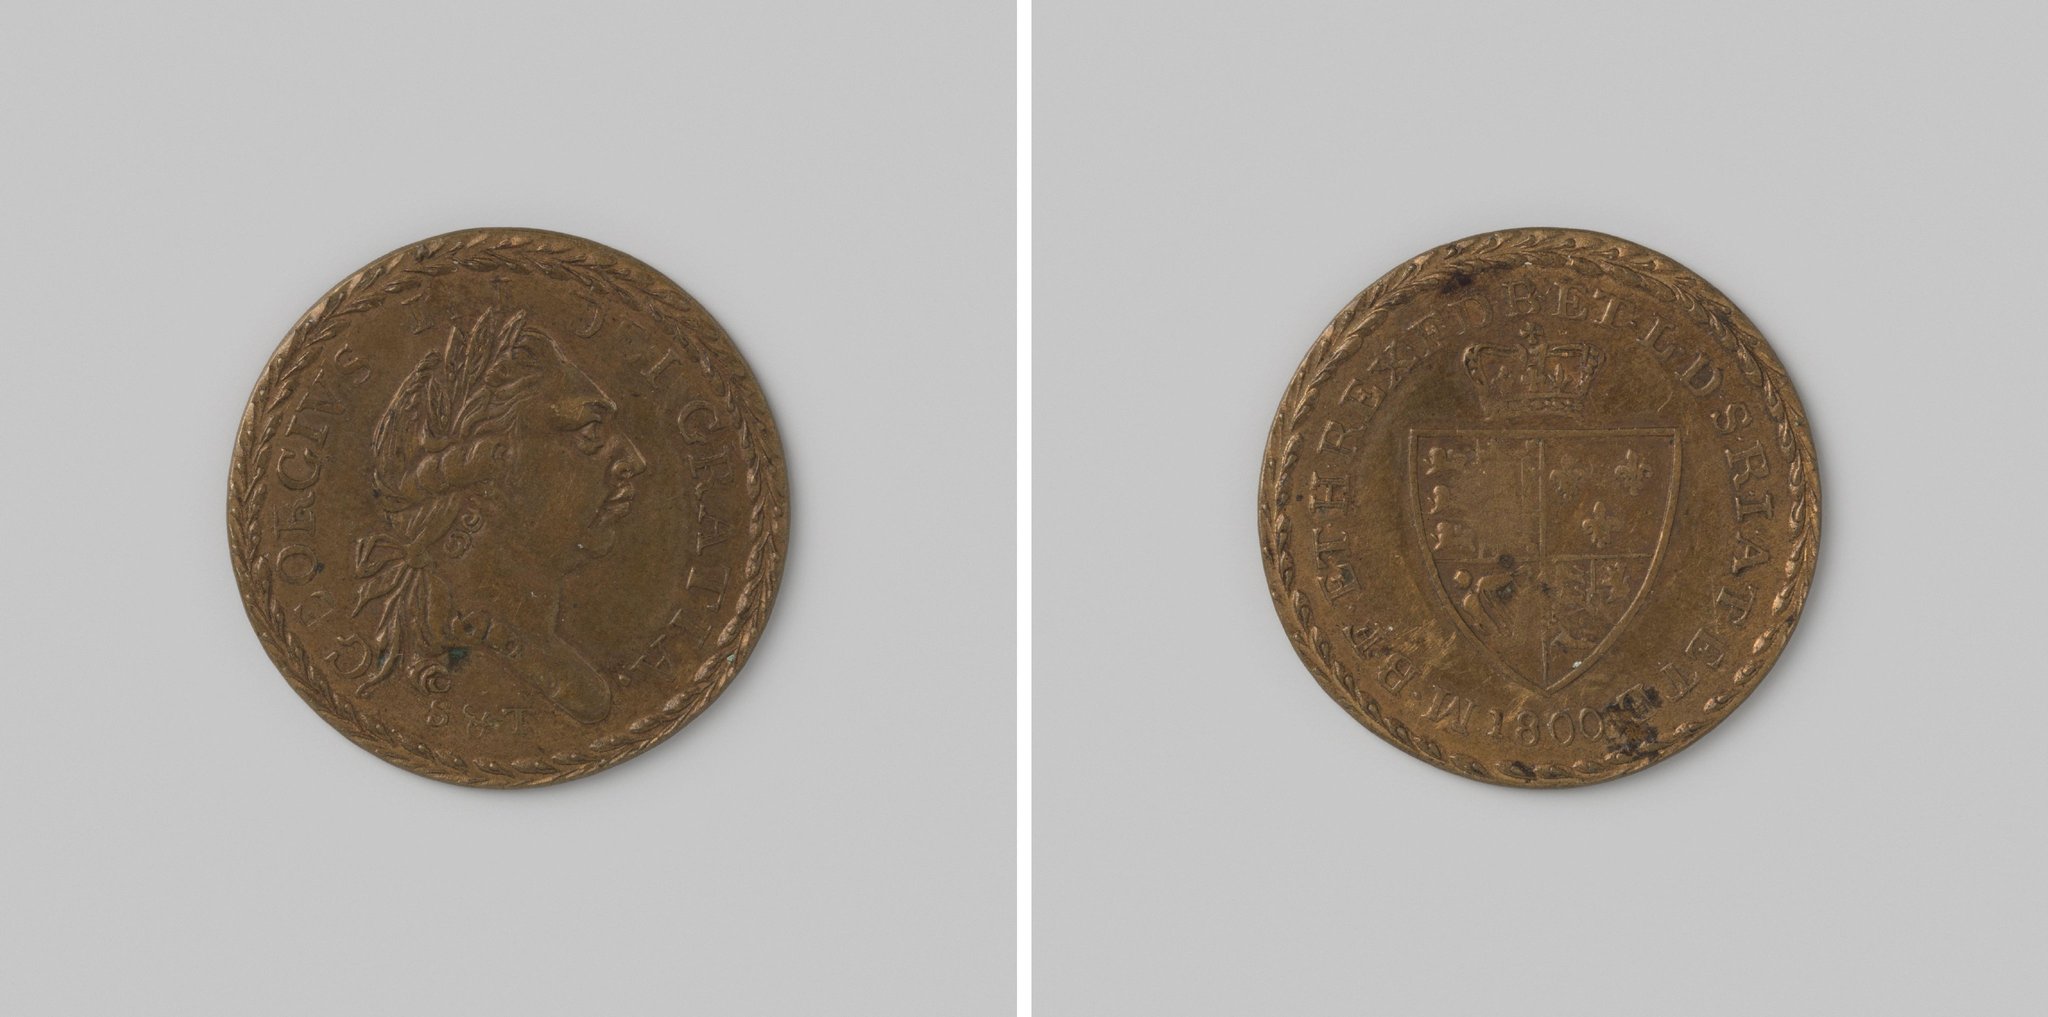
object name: history medal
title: Engelse speelpenning type spade guinea 1800 S&T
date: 1800-1818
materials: brass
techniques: striking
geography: birmingham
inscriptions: signature: ‘S & T’, circumscription: ‘M. B. F. ET. H. REX. F. D. B. ET. L. D. S. R. I. A. T. ETE’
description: Messing penning, op de voorzijde het portret van George III, met omschrift, binnen een lauwerkrans, op de keerzijde een gekroond wapenschild met omschrift binnen een lauwerkrans.